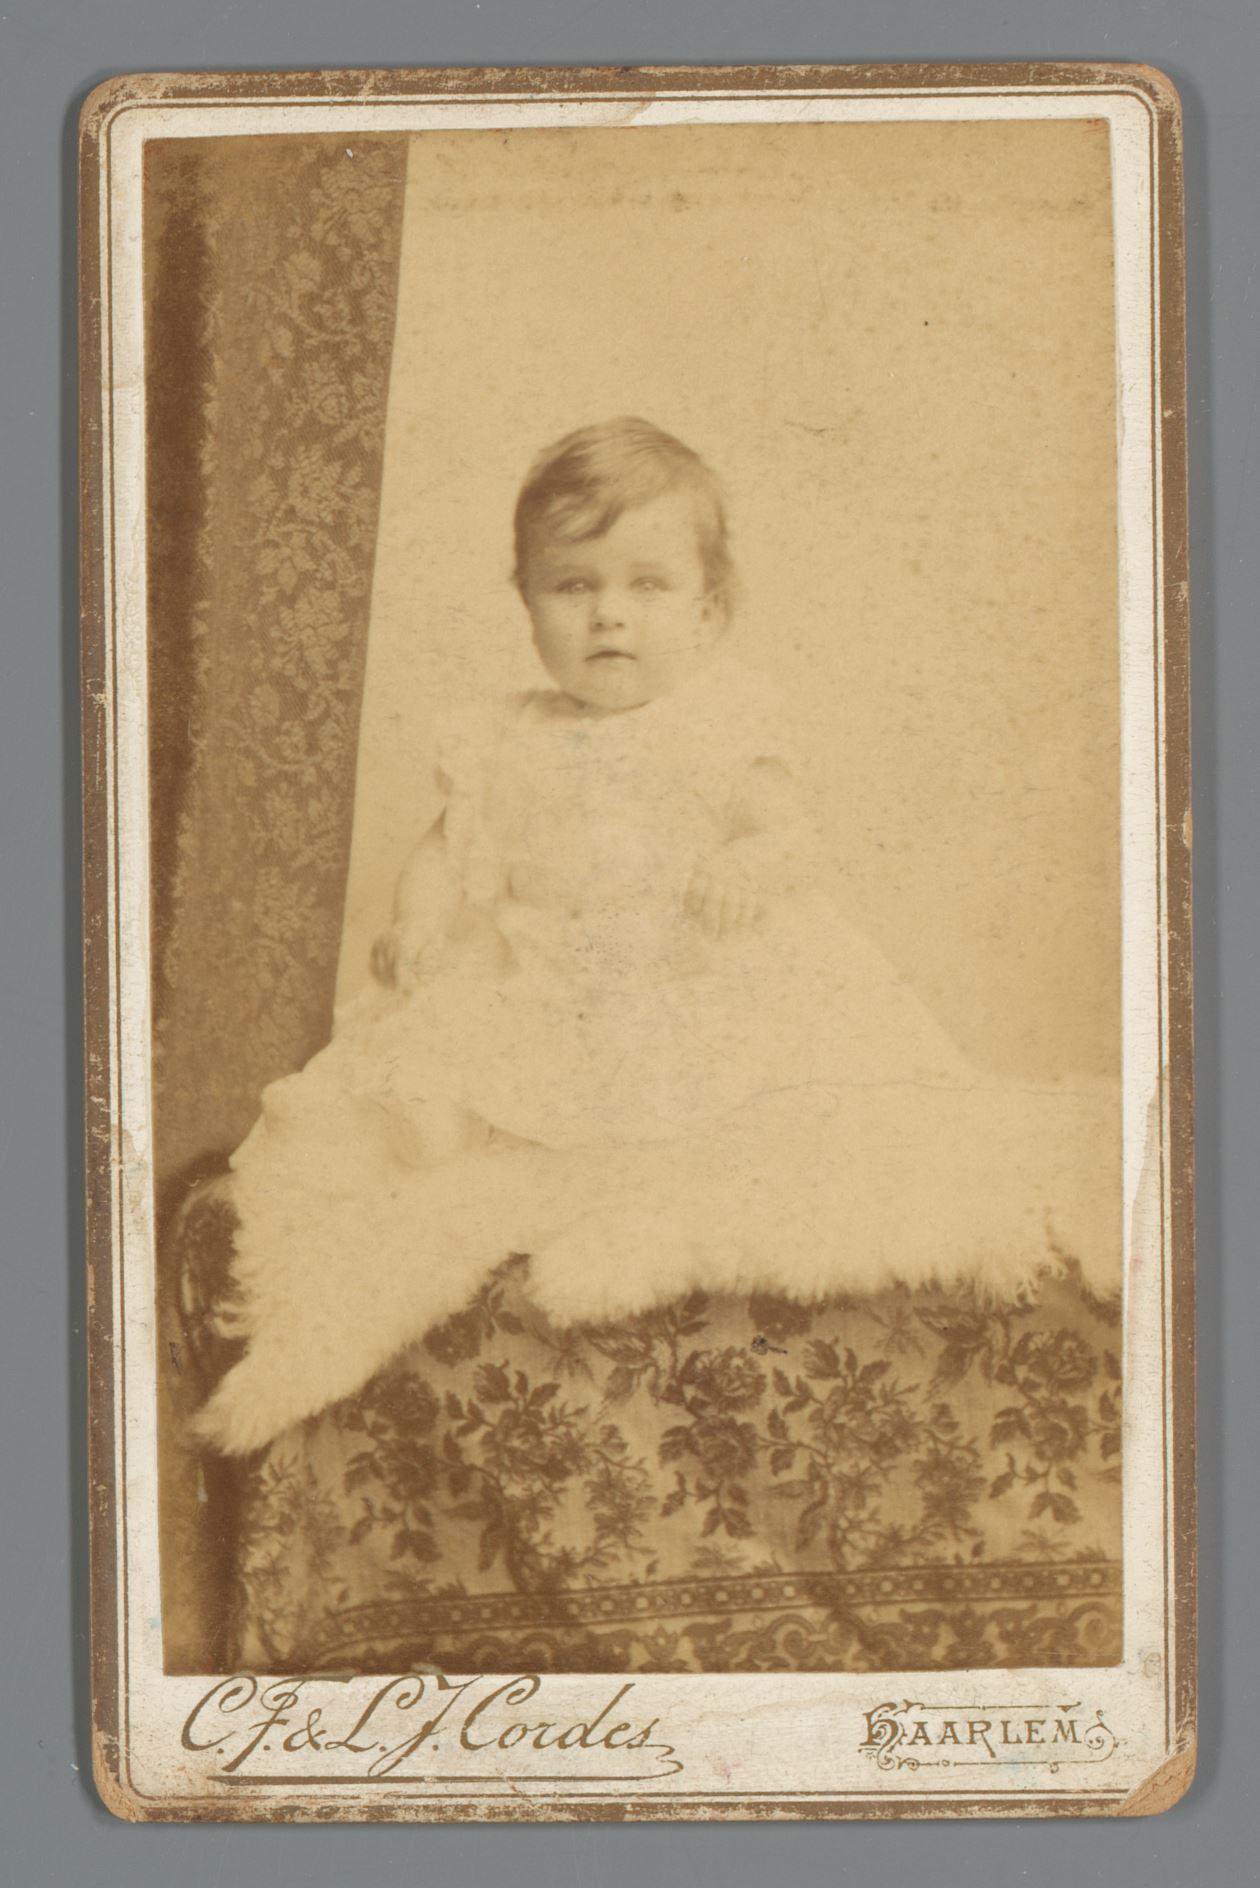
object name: carte de visite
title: Portret van Johanna Geertruida Jonker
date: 1895-1896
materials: cardboard, photographic support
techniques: albumen print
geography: haarlem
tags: historical persons, haarlem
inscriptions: annotation: ‘Hansje Jonker’, workshop stamp: ‘C.F. & L.J. Cordes/ Haarlem, Groote Houtstraat 84/ 's Bosch a/d. Parade’